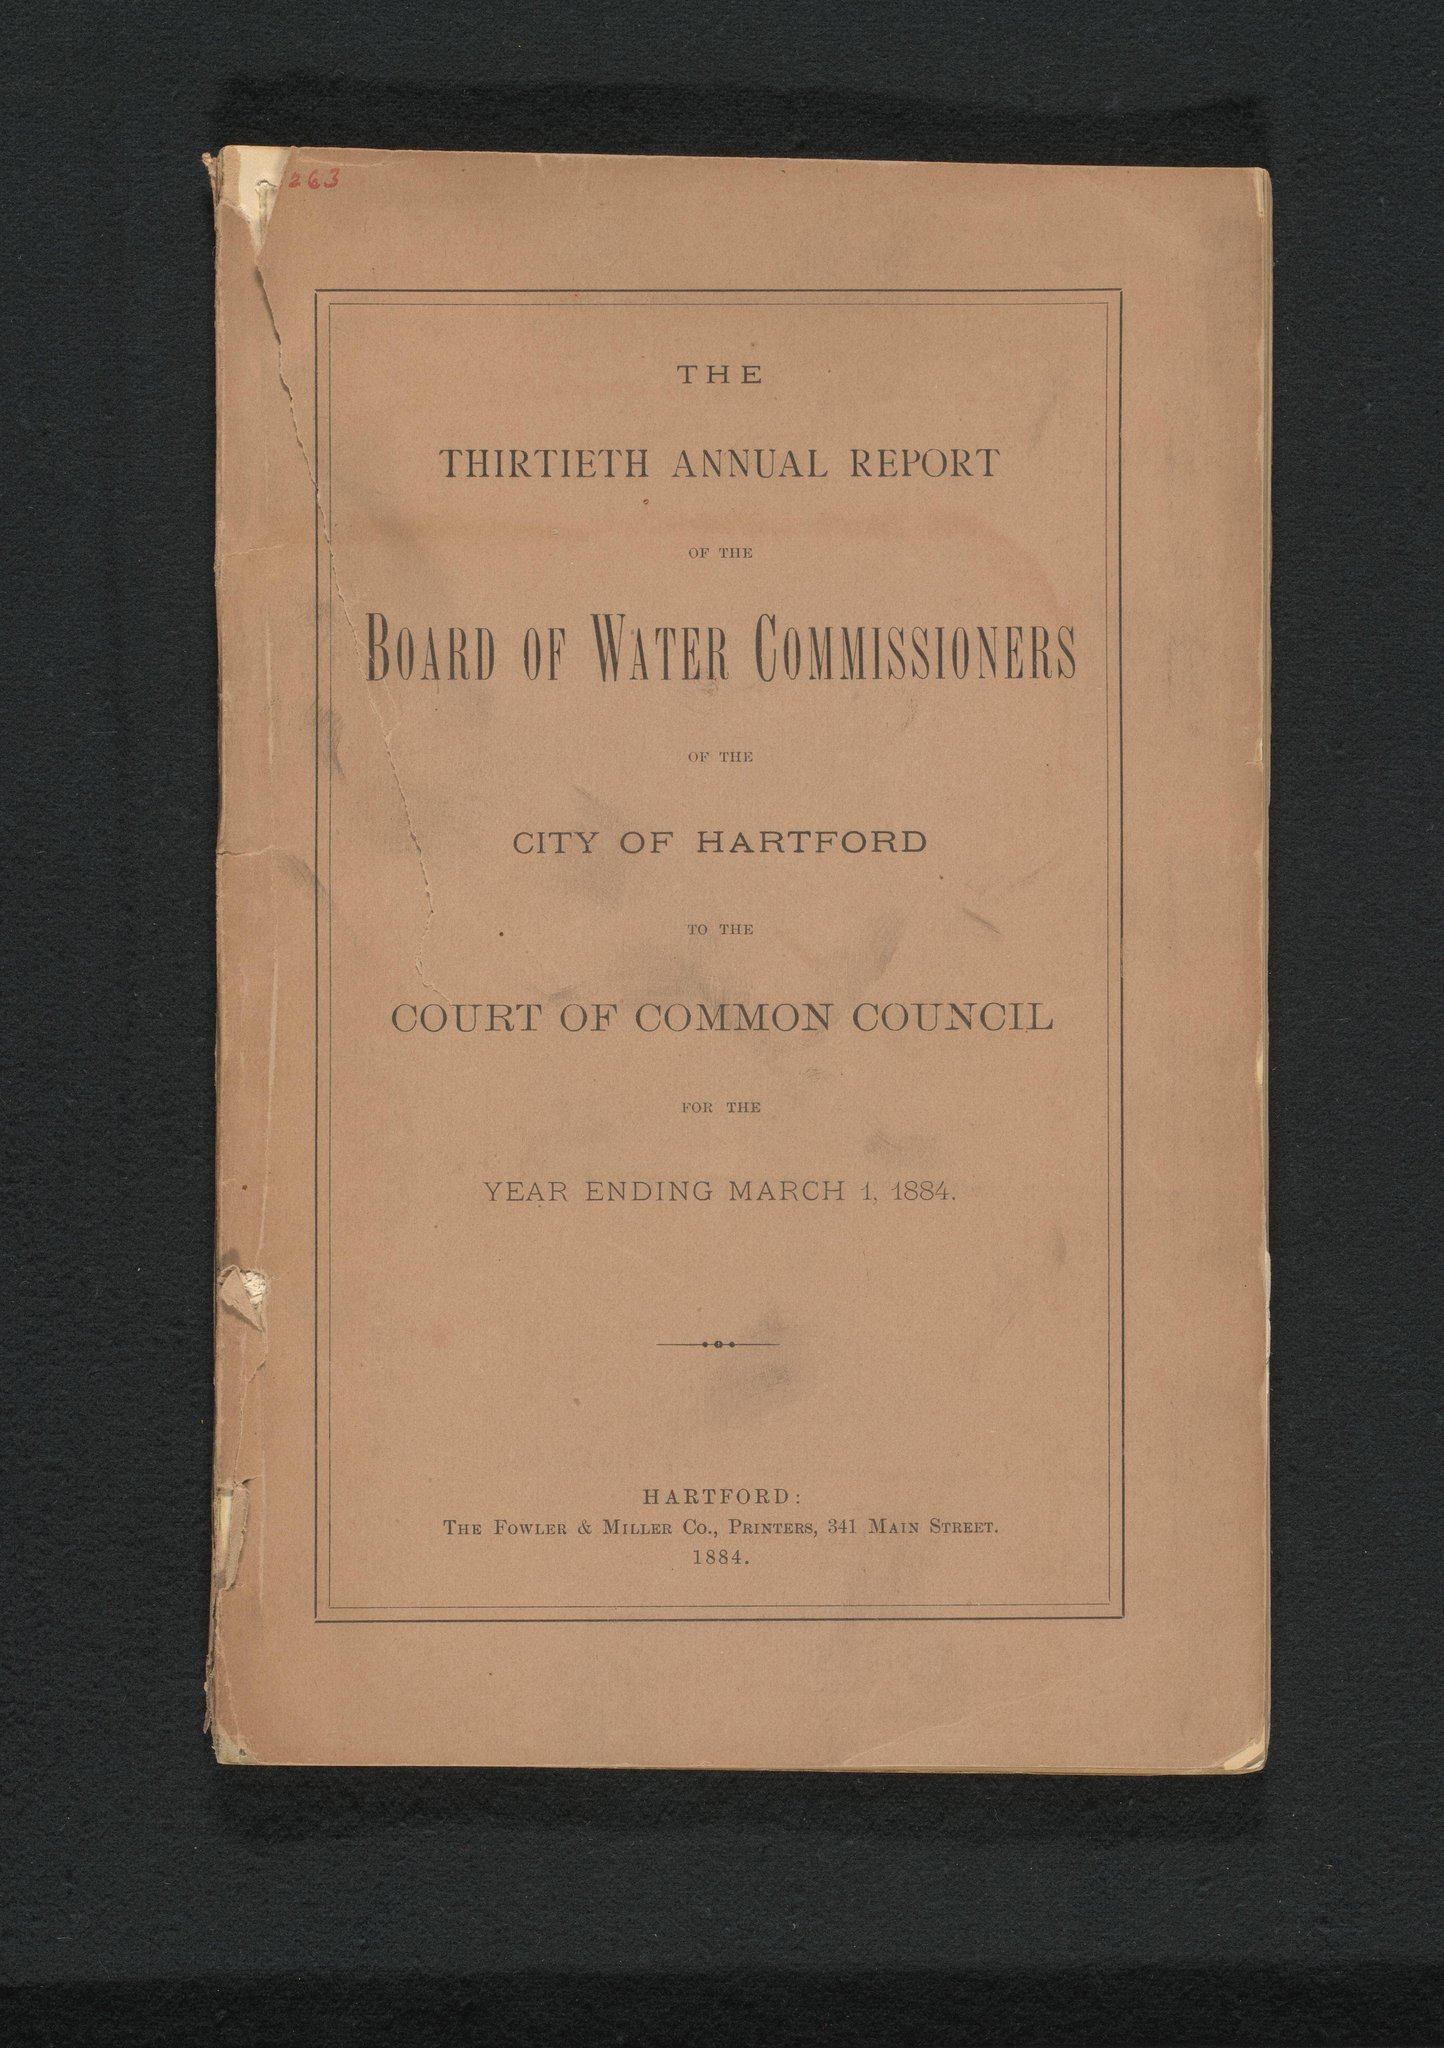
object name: book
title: The thirtieth Annual report of the Board of Water Commissioners of the city of Hartford to the Court of Common Council for the year ending March 1, 1884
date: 1884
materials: paper, photographic support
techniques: albumen print, printing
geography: hartford